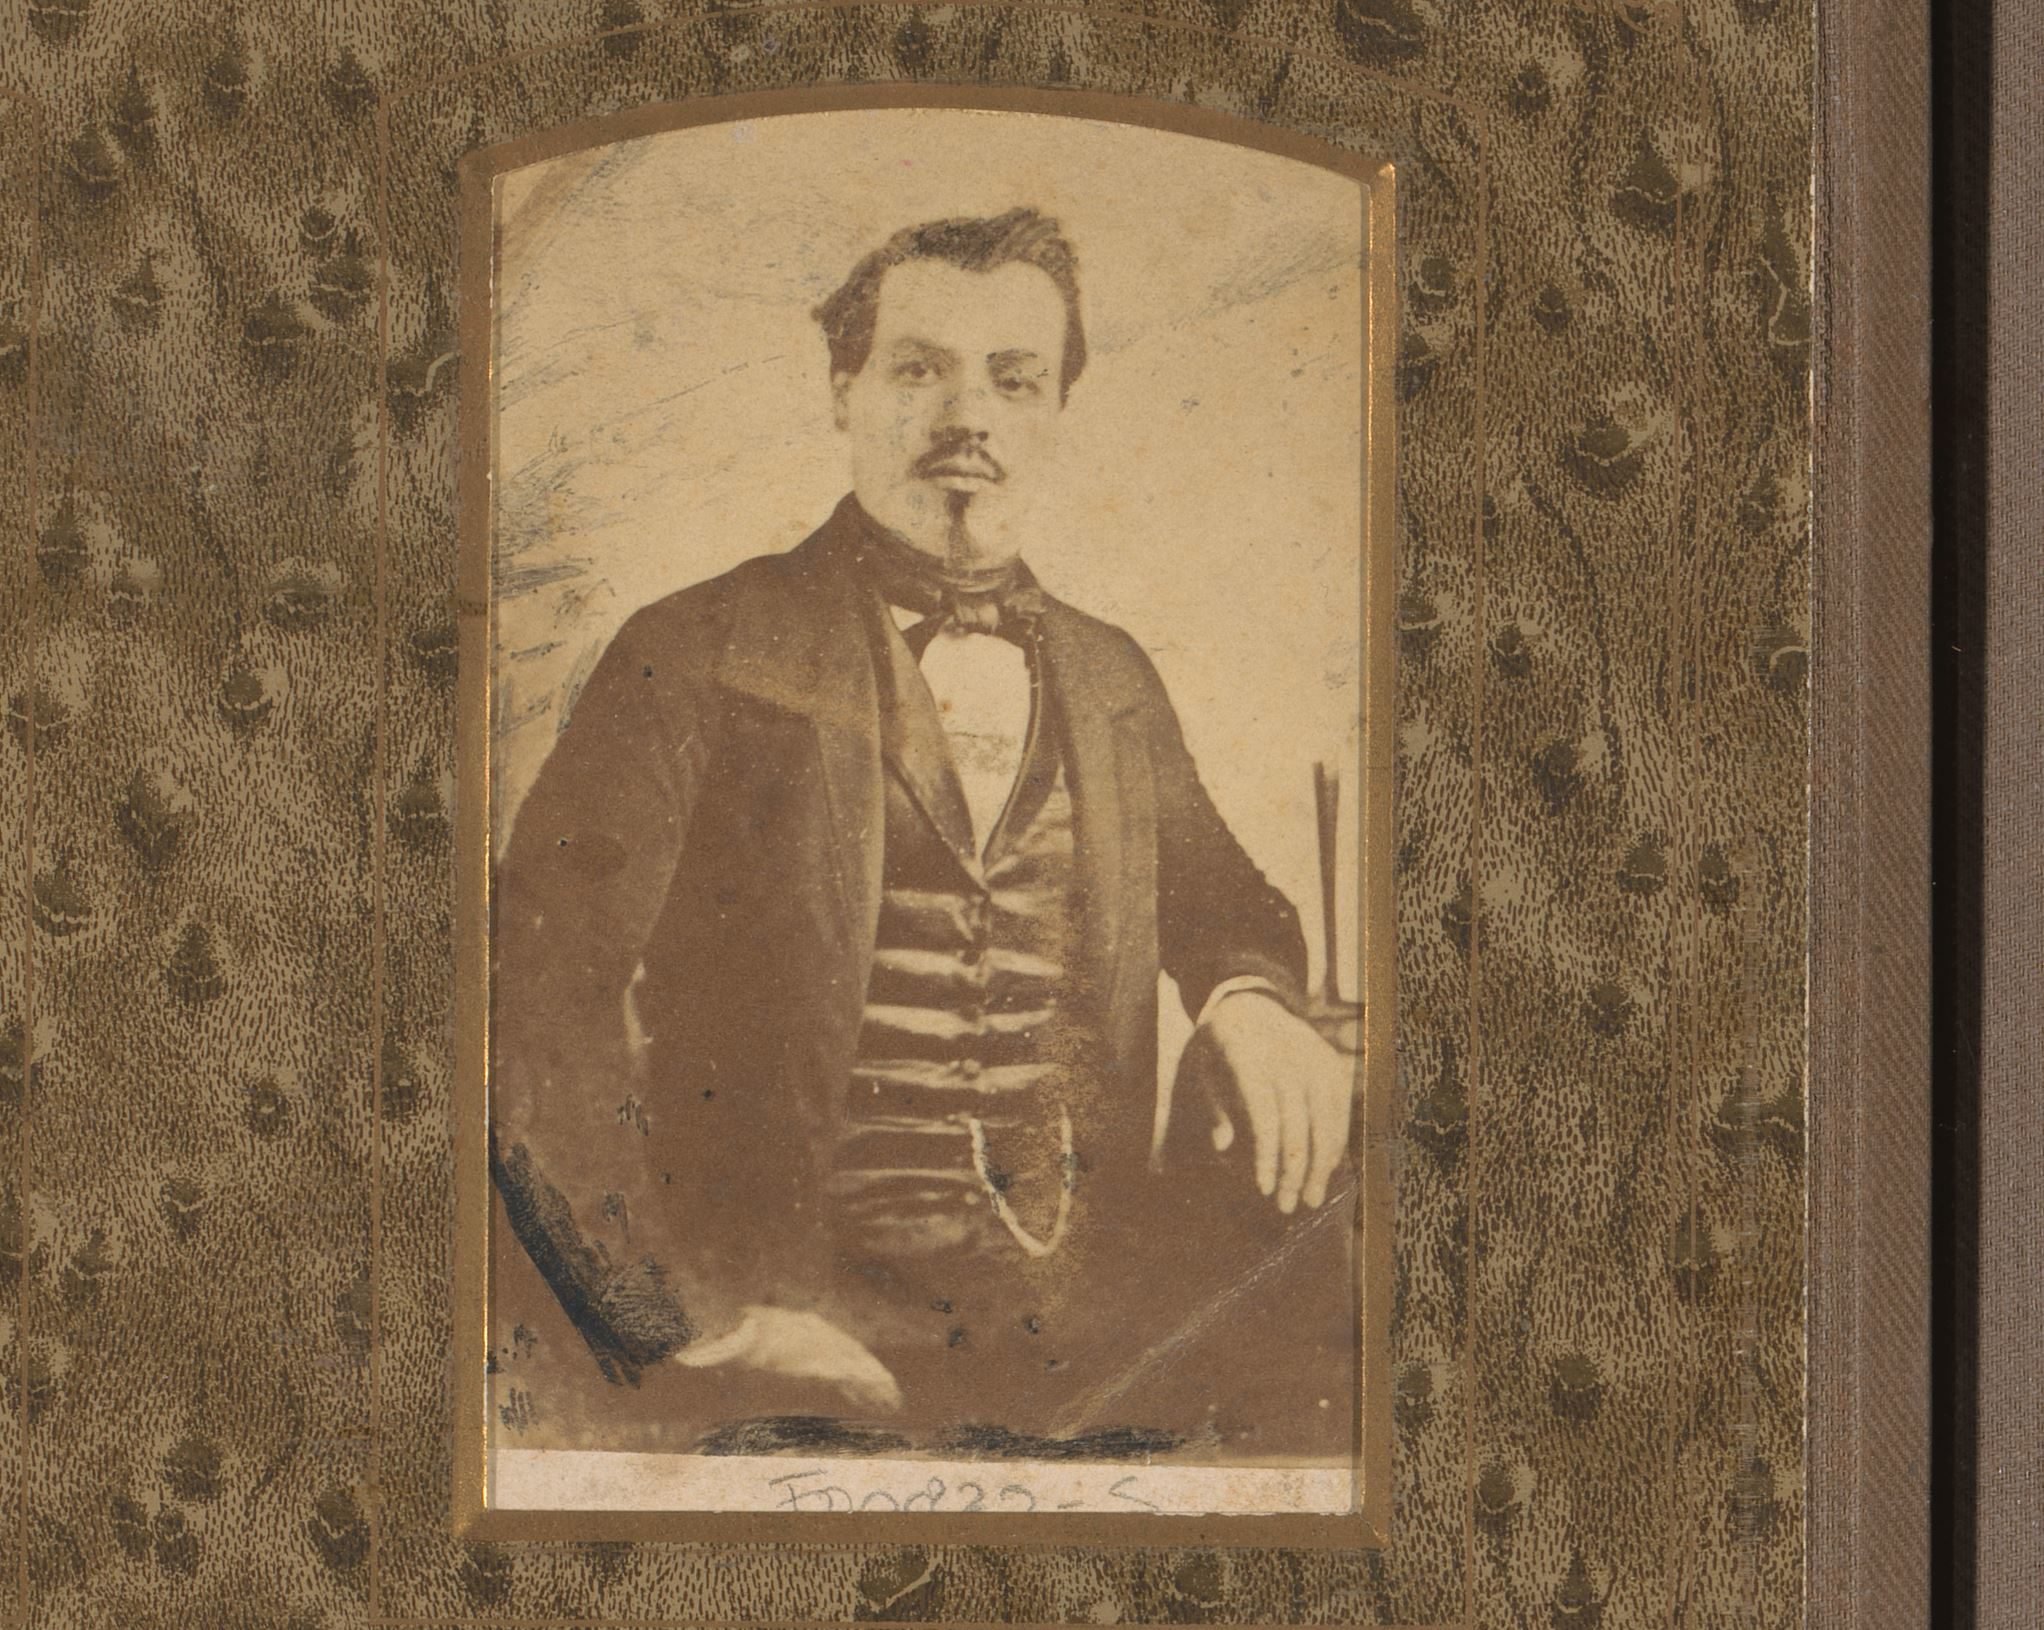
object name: carte de visite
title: Portret van een zittende man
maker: victor lapouge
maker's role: fotograaf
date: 1850-1900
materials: cardboard, photographic support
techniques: albumen print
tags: sitting figure, historical persons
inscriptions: inscription: ‘LAPOUGE/ PHOTOGRAPHE/ RUE MONTORGE. 12’